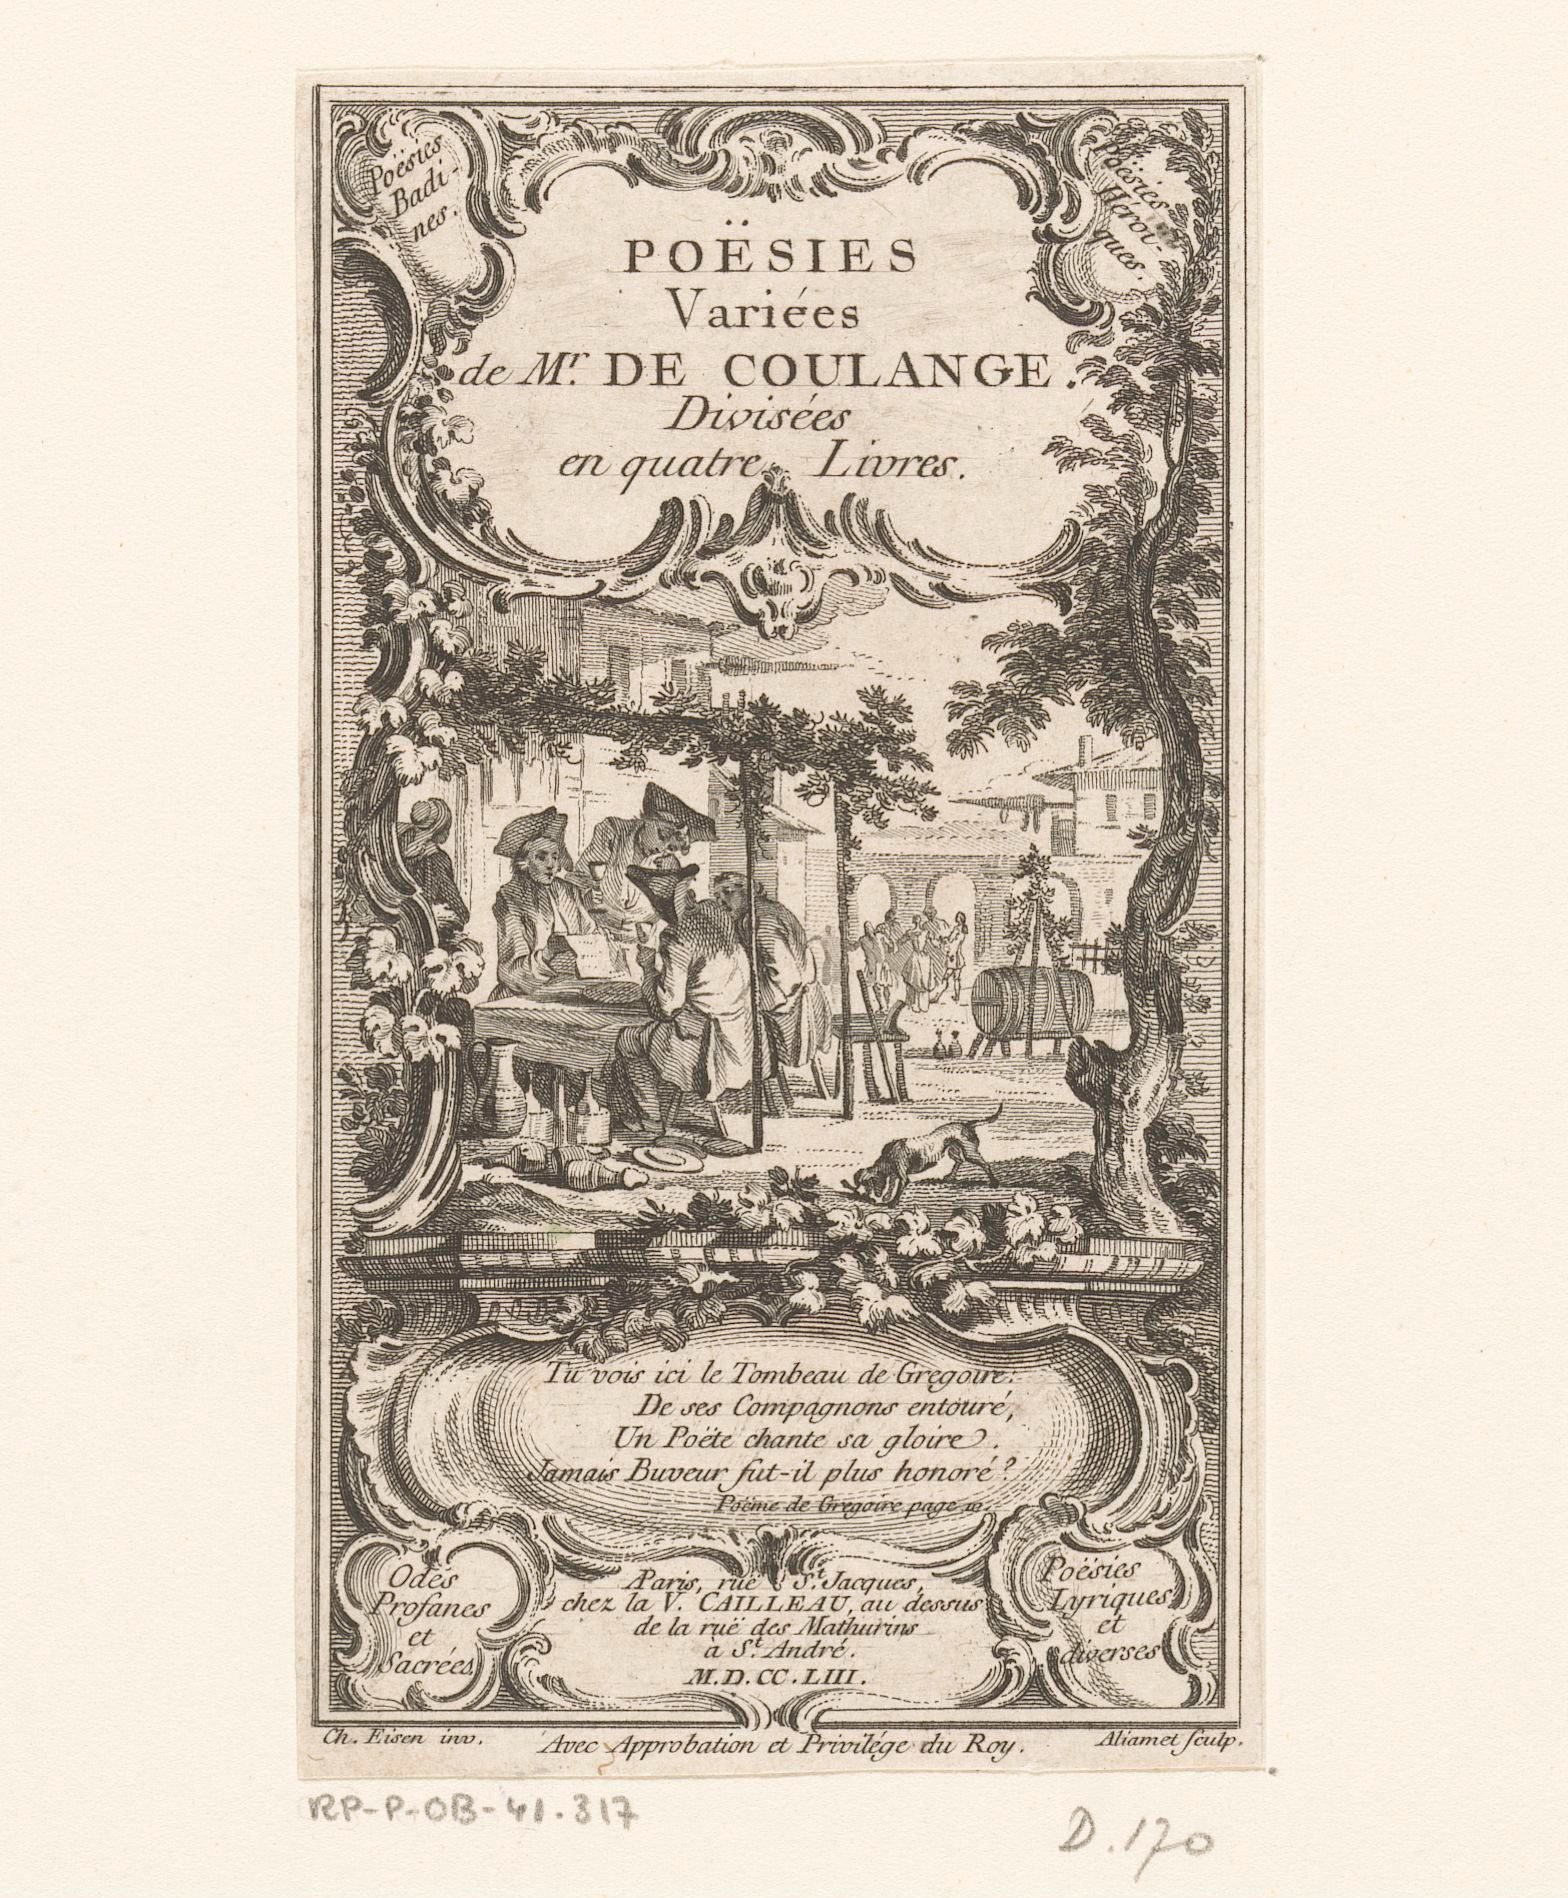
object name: titelblad, titelpagina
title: Figuren op de binnenplaats van een herberg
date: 1753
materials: paper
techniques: engraving, etching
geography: paris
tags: wooden container: barrel, cask, bucket, sitting figure, inn, coffee-house, public house, etc.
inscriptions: collector's mark: Lugt 2228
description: Titelpagina voor Coulange, N. de, Poësies variées. Parijs: weduwe A. Cailleau, 1753.